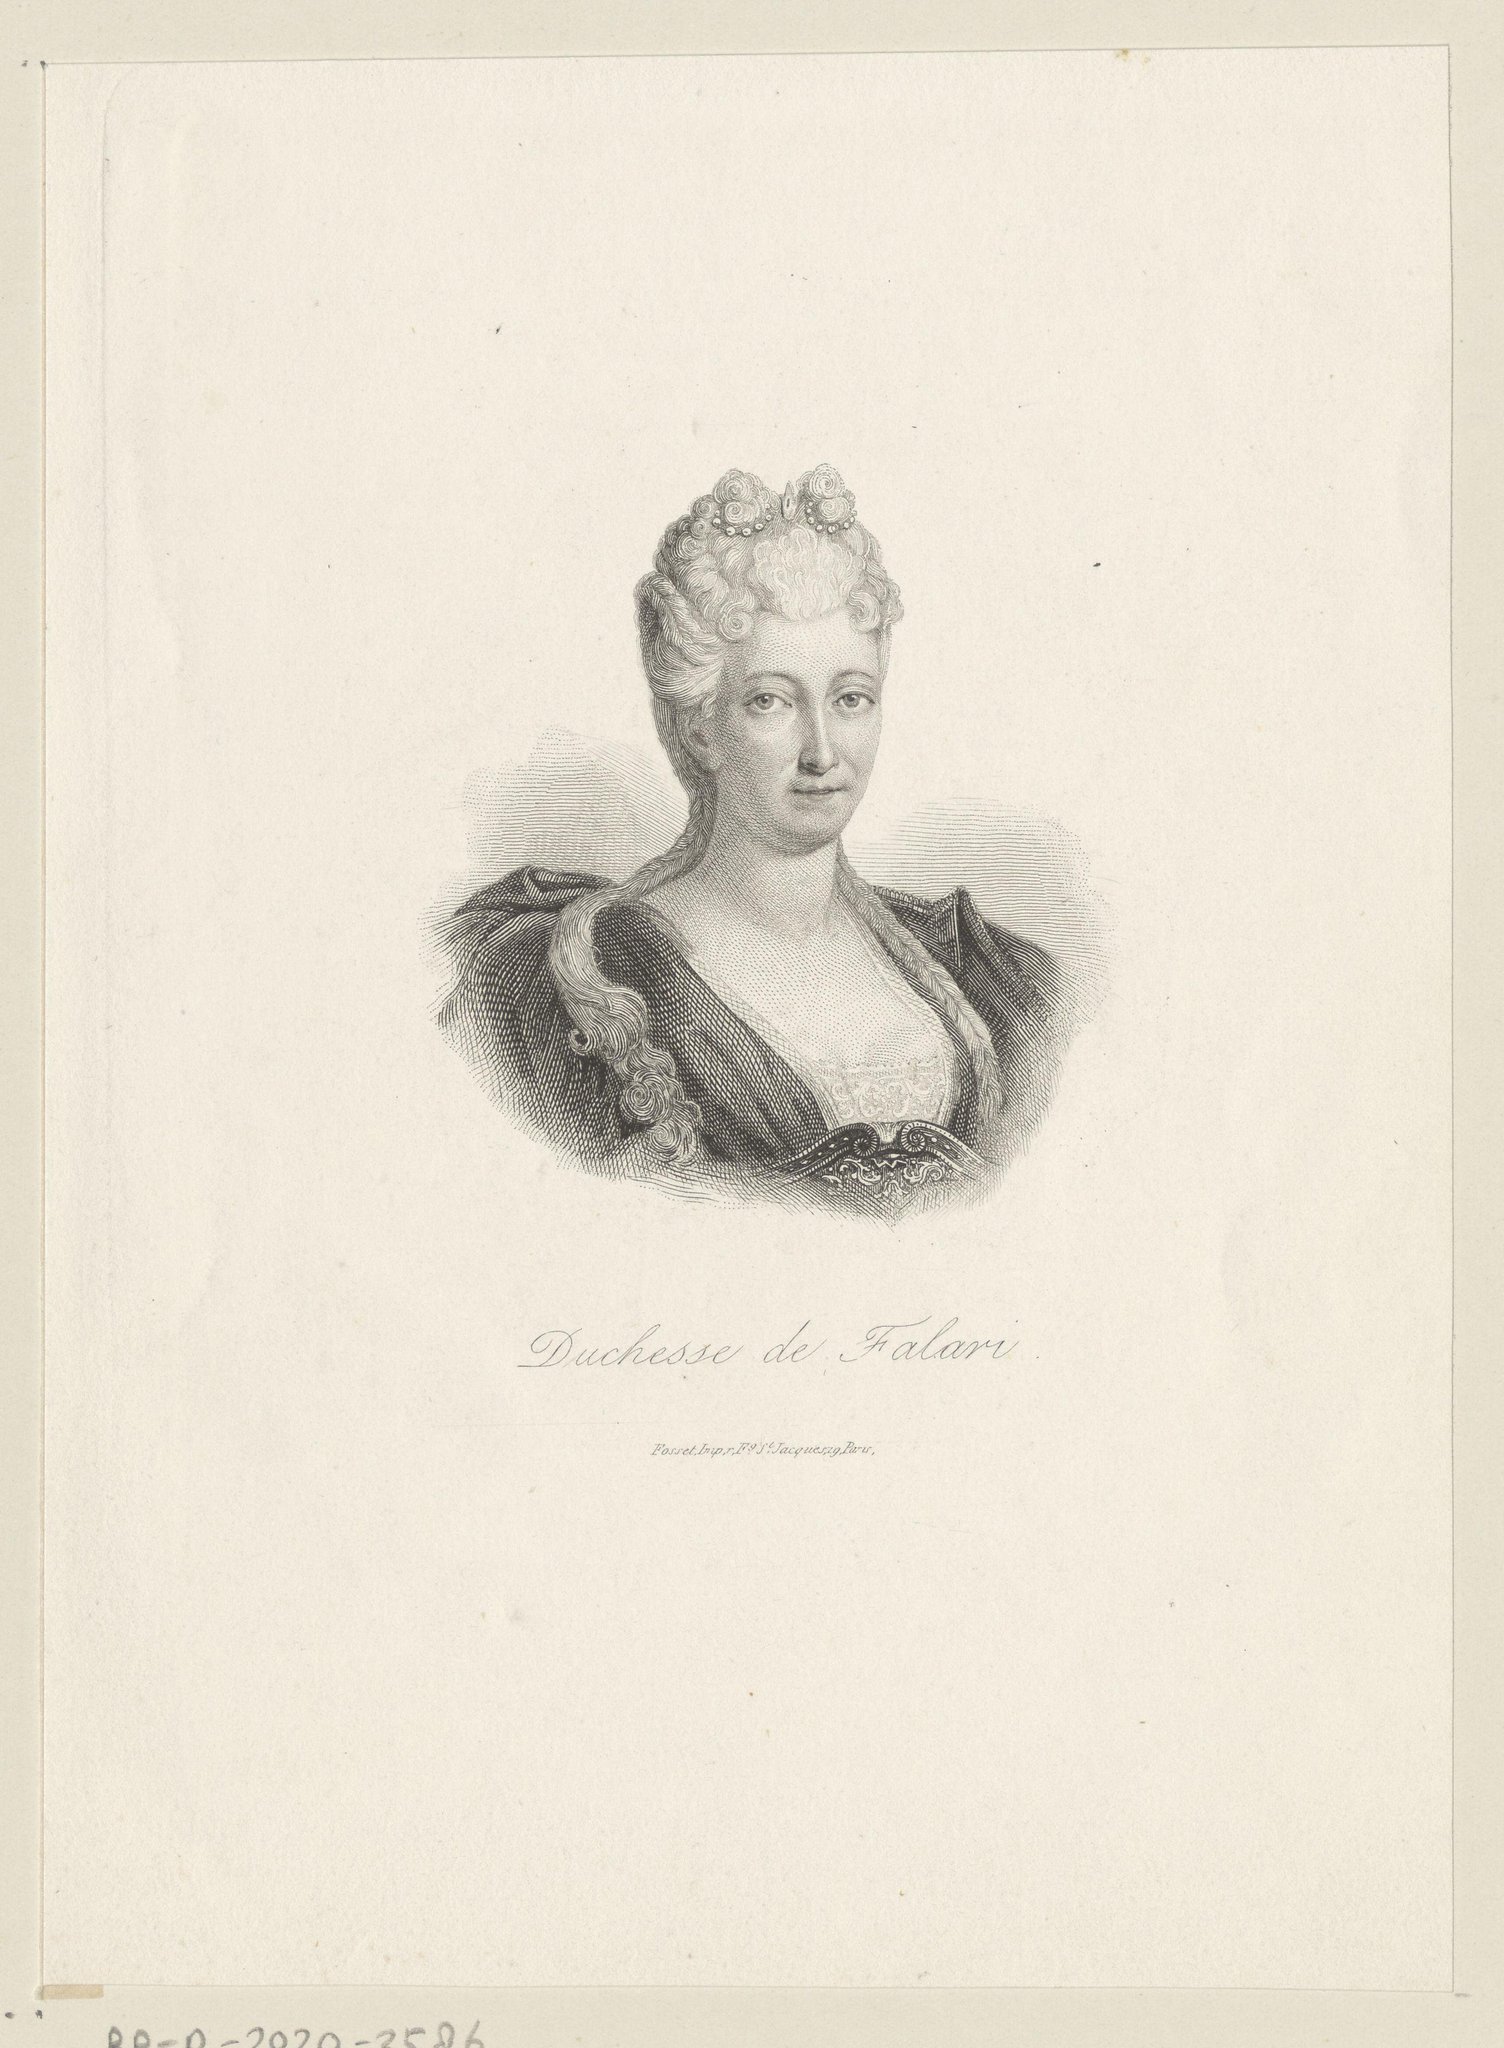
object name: print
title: Portret van de hertogin van Falari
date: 1830-1880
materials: paper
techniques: etching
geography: paris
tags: historical persons - bb - woman